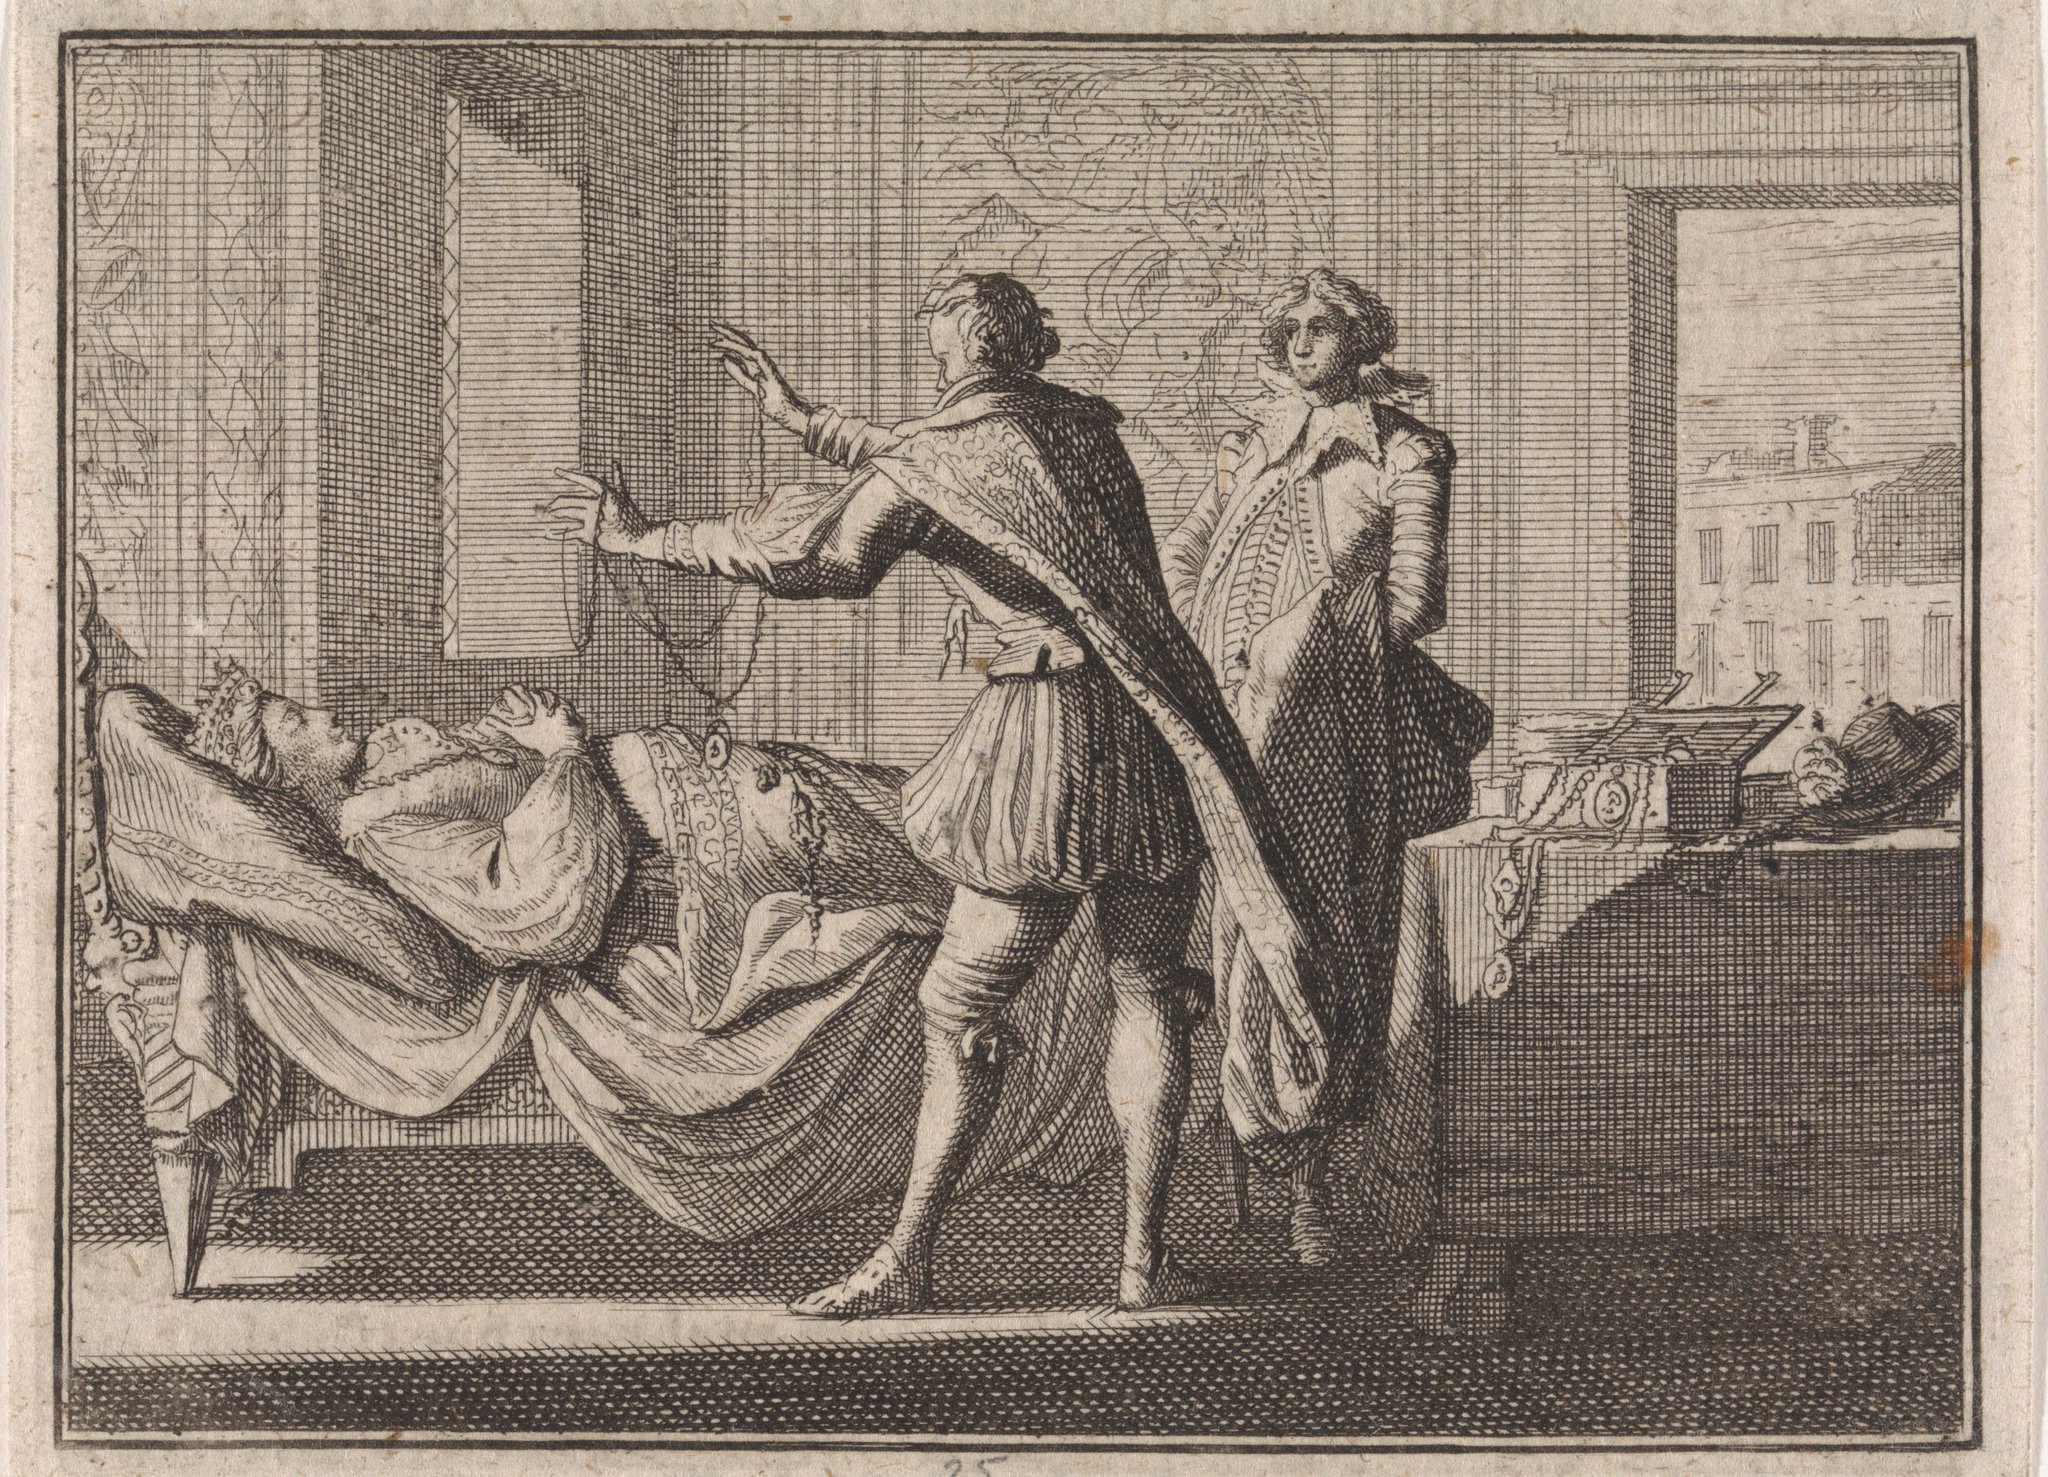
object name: print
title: Die unlöbliche schwartze Kunst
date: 1710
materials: paper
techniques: etching, letterpress printing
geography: nuremberg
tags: charlemagne (holy roman emperor), putting on jewels - aa - (for) women (+ variant), the corpse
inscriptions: collector's mark: Lugt 2228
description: Illustratie uit: Abraham a Sancta Clara. Heilsames Gemisch Gemasch, das ist: Allerley seltsame und verwunderliche Geschichten (...). Neurenberg: Christoph Weigel, 1710, p. 231.